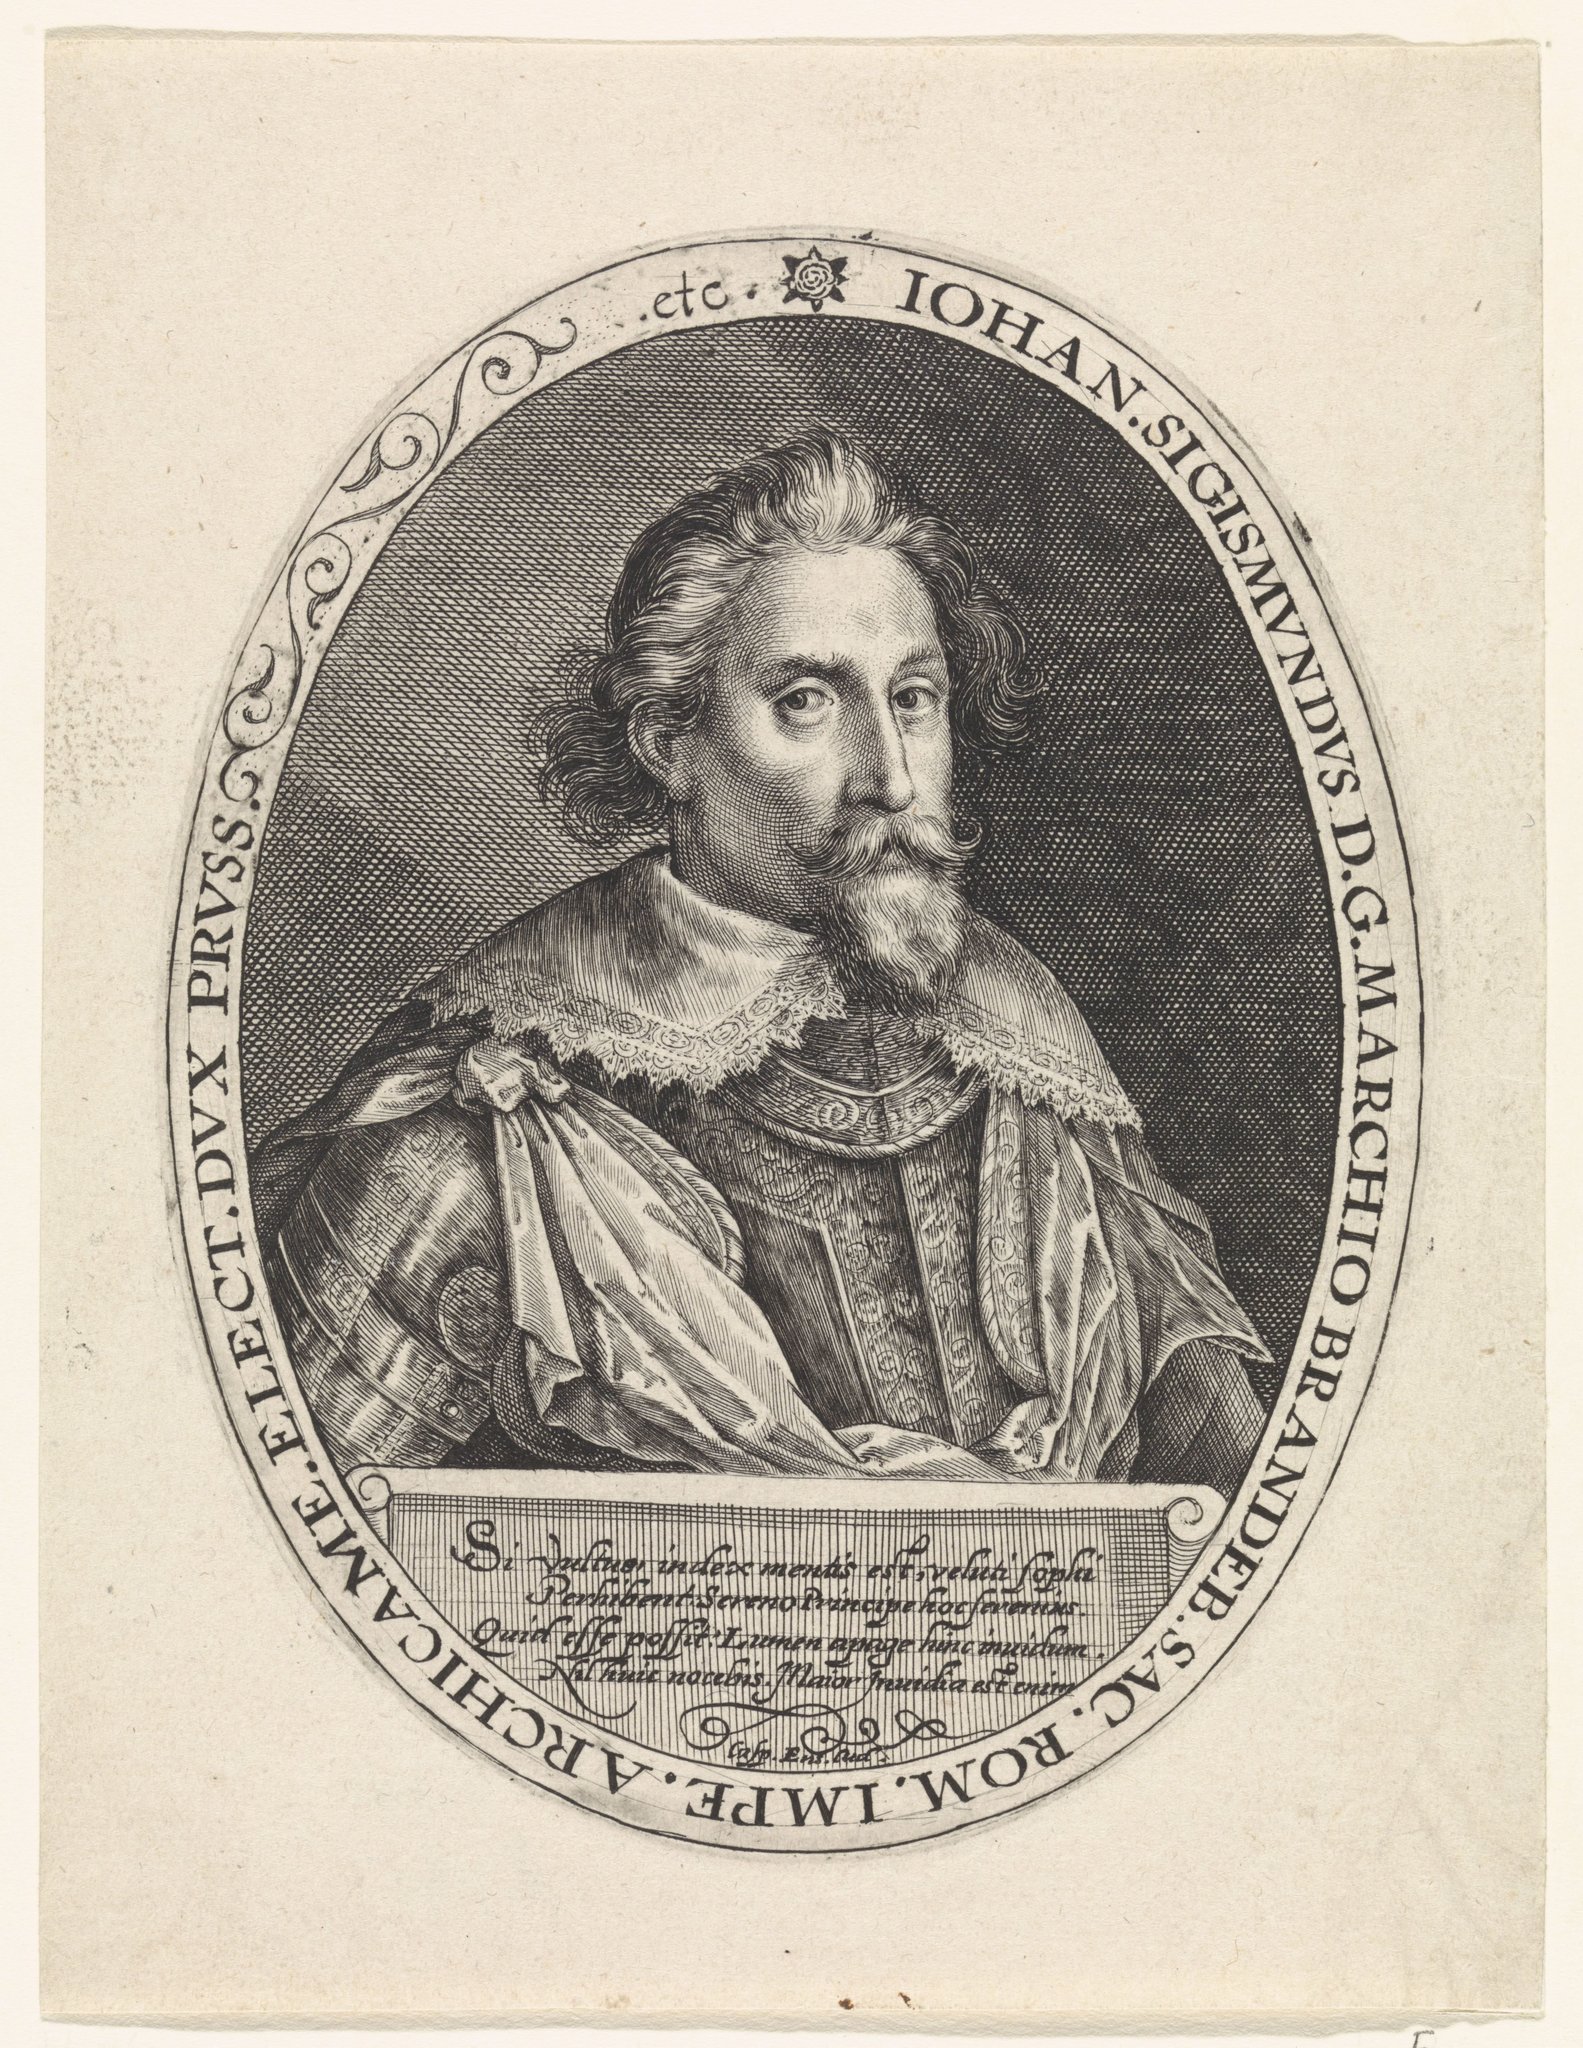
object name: print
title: Portret van Johann Sigismund, keurvorst van Brandenburg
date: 1610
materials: paper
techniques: engraving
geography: cologne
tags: keurvorst, johan sigismund brandenburg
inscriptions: collector's mark: Lugt 2228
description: Portret van Johann Sigismund, keurvorst van Brandenburg, met daaronder een vierregelig lofdicht in het Latijn. In het randschrift van de omlijsting de naam en functie van de geportretteerde in het Latijn.